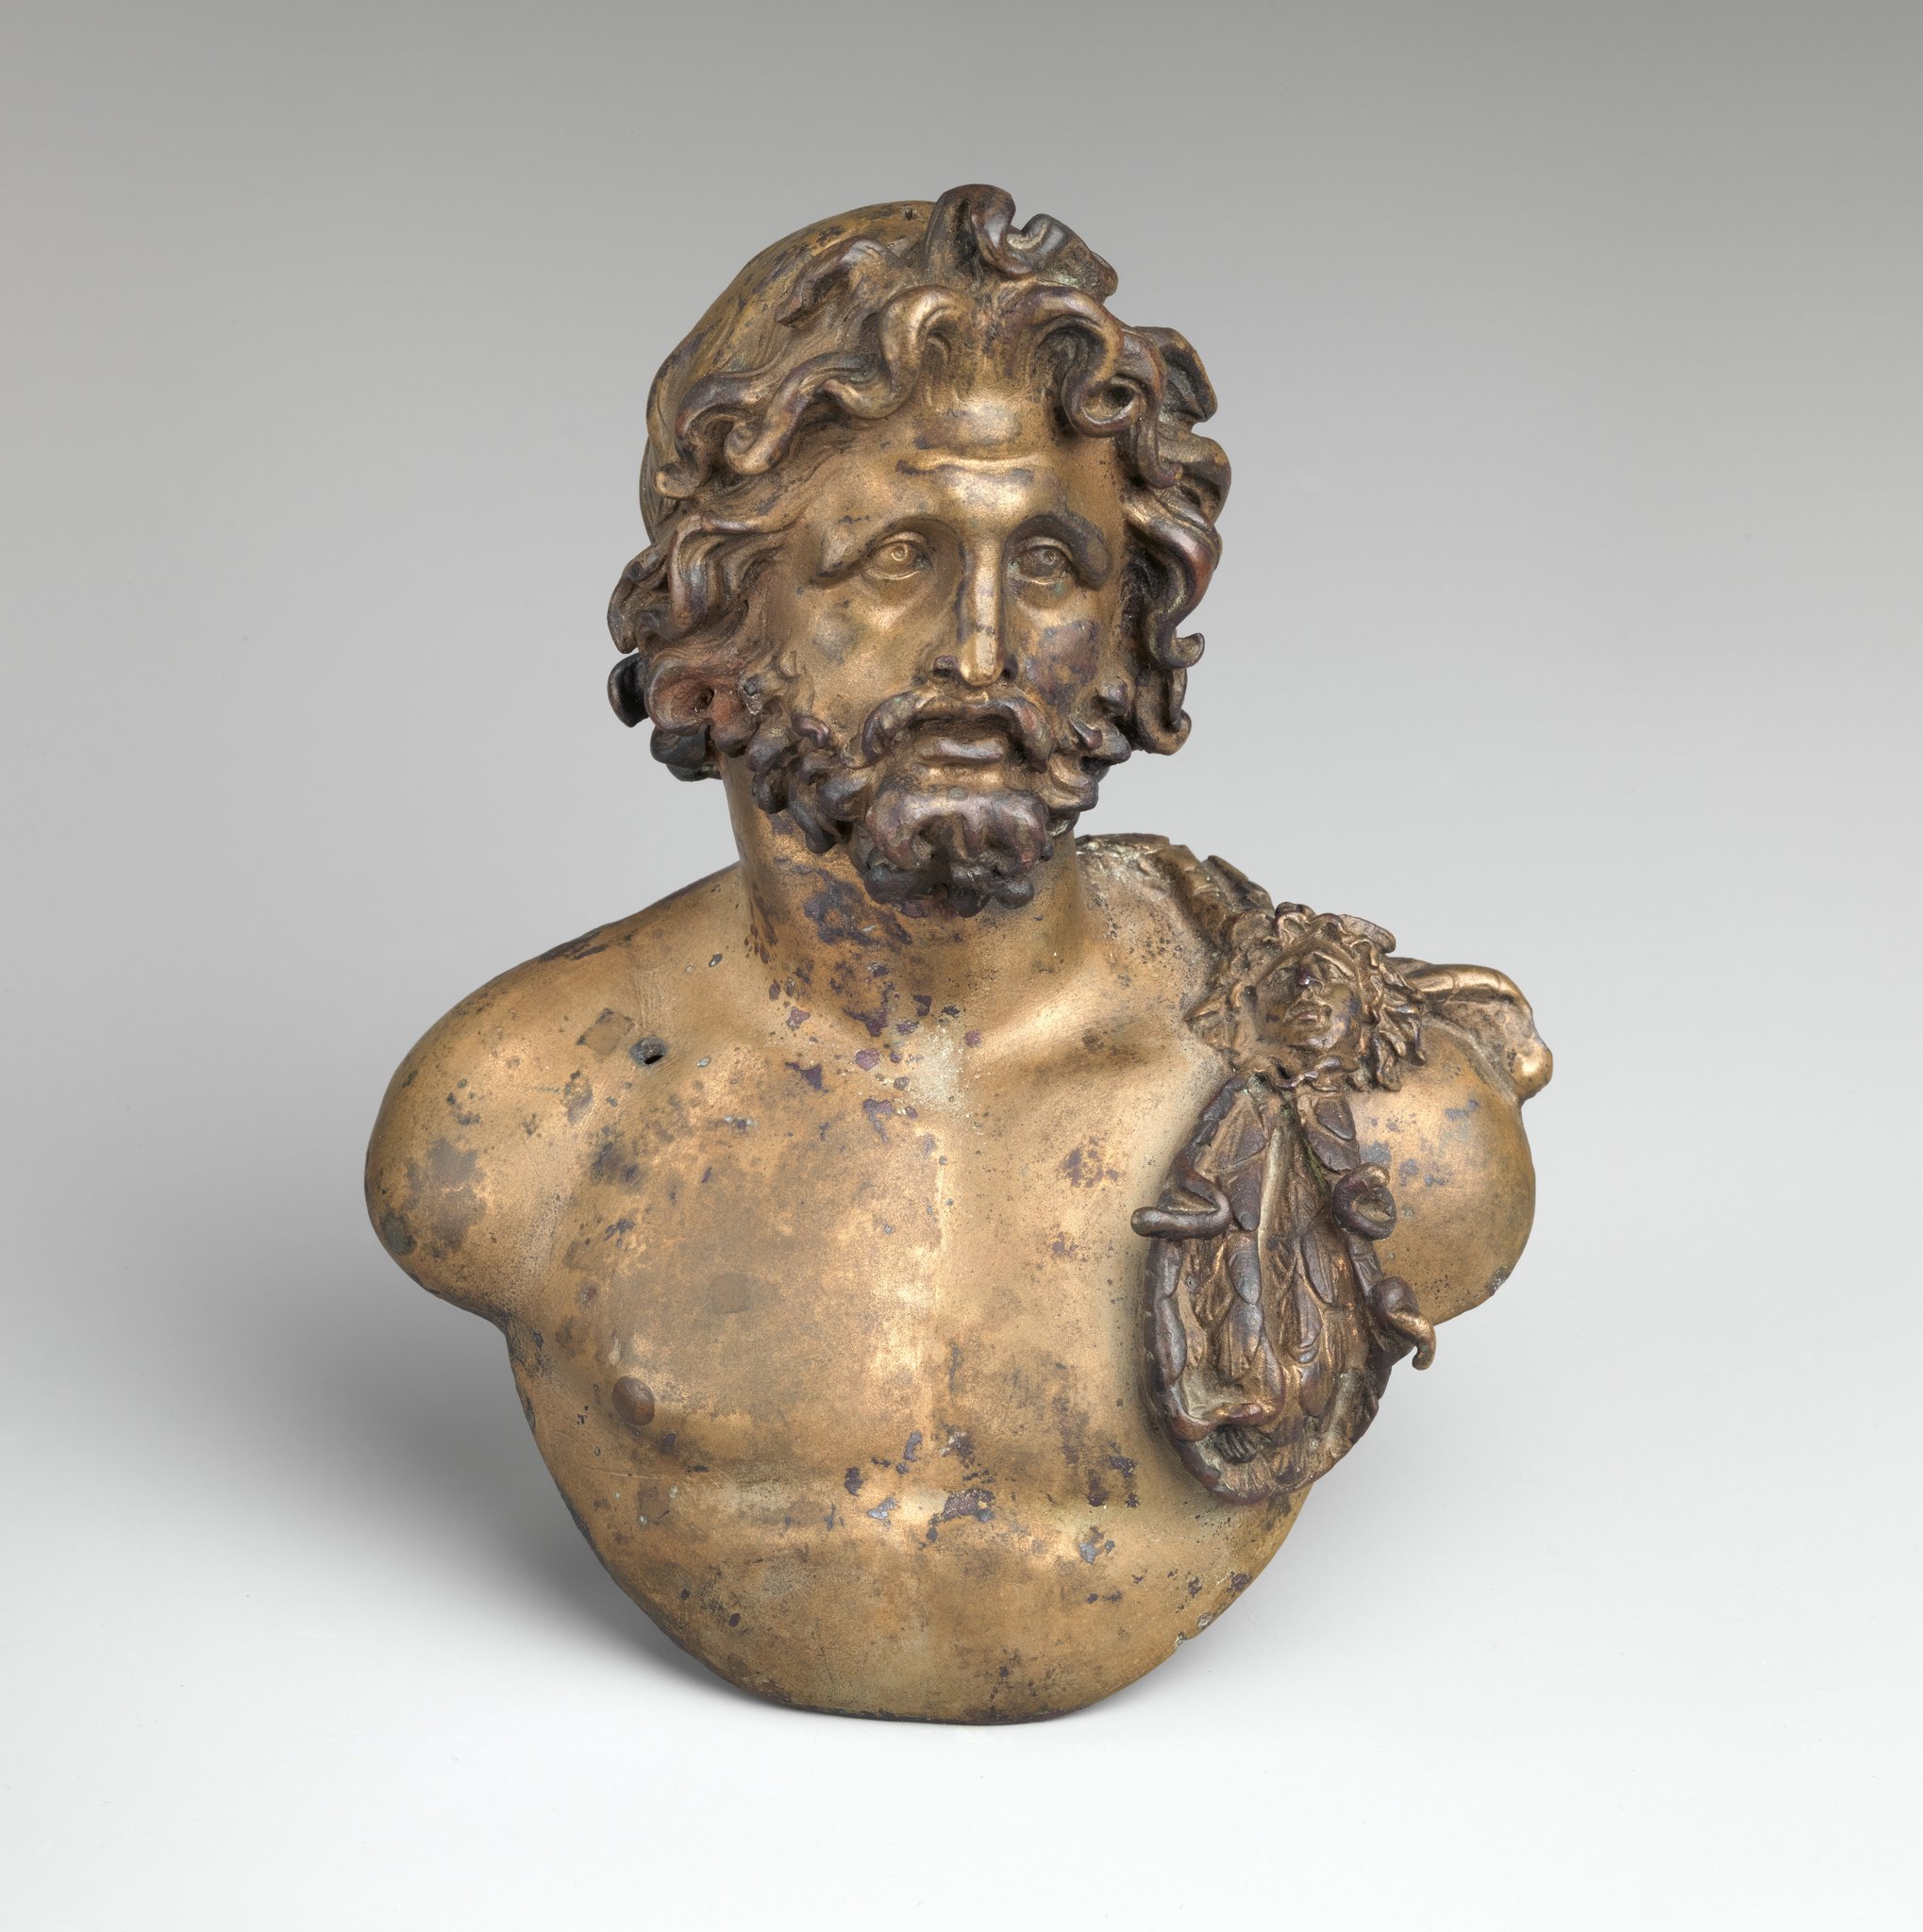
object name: bust of zeus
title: Bronze bust of Jupiter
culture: roman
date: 34 BCE-100 CE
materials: bronze, copper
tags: jupiter